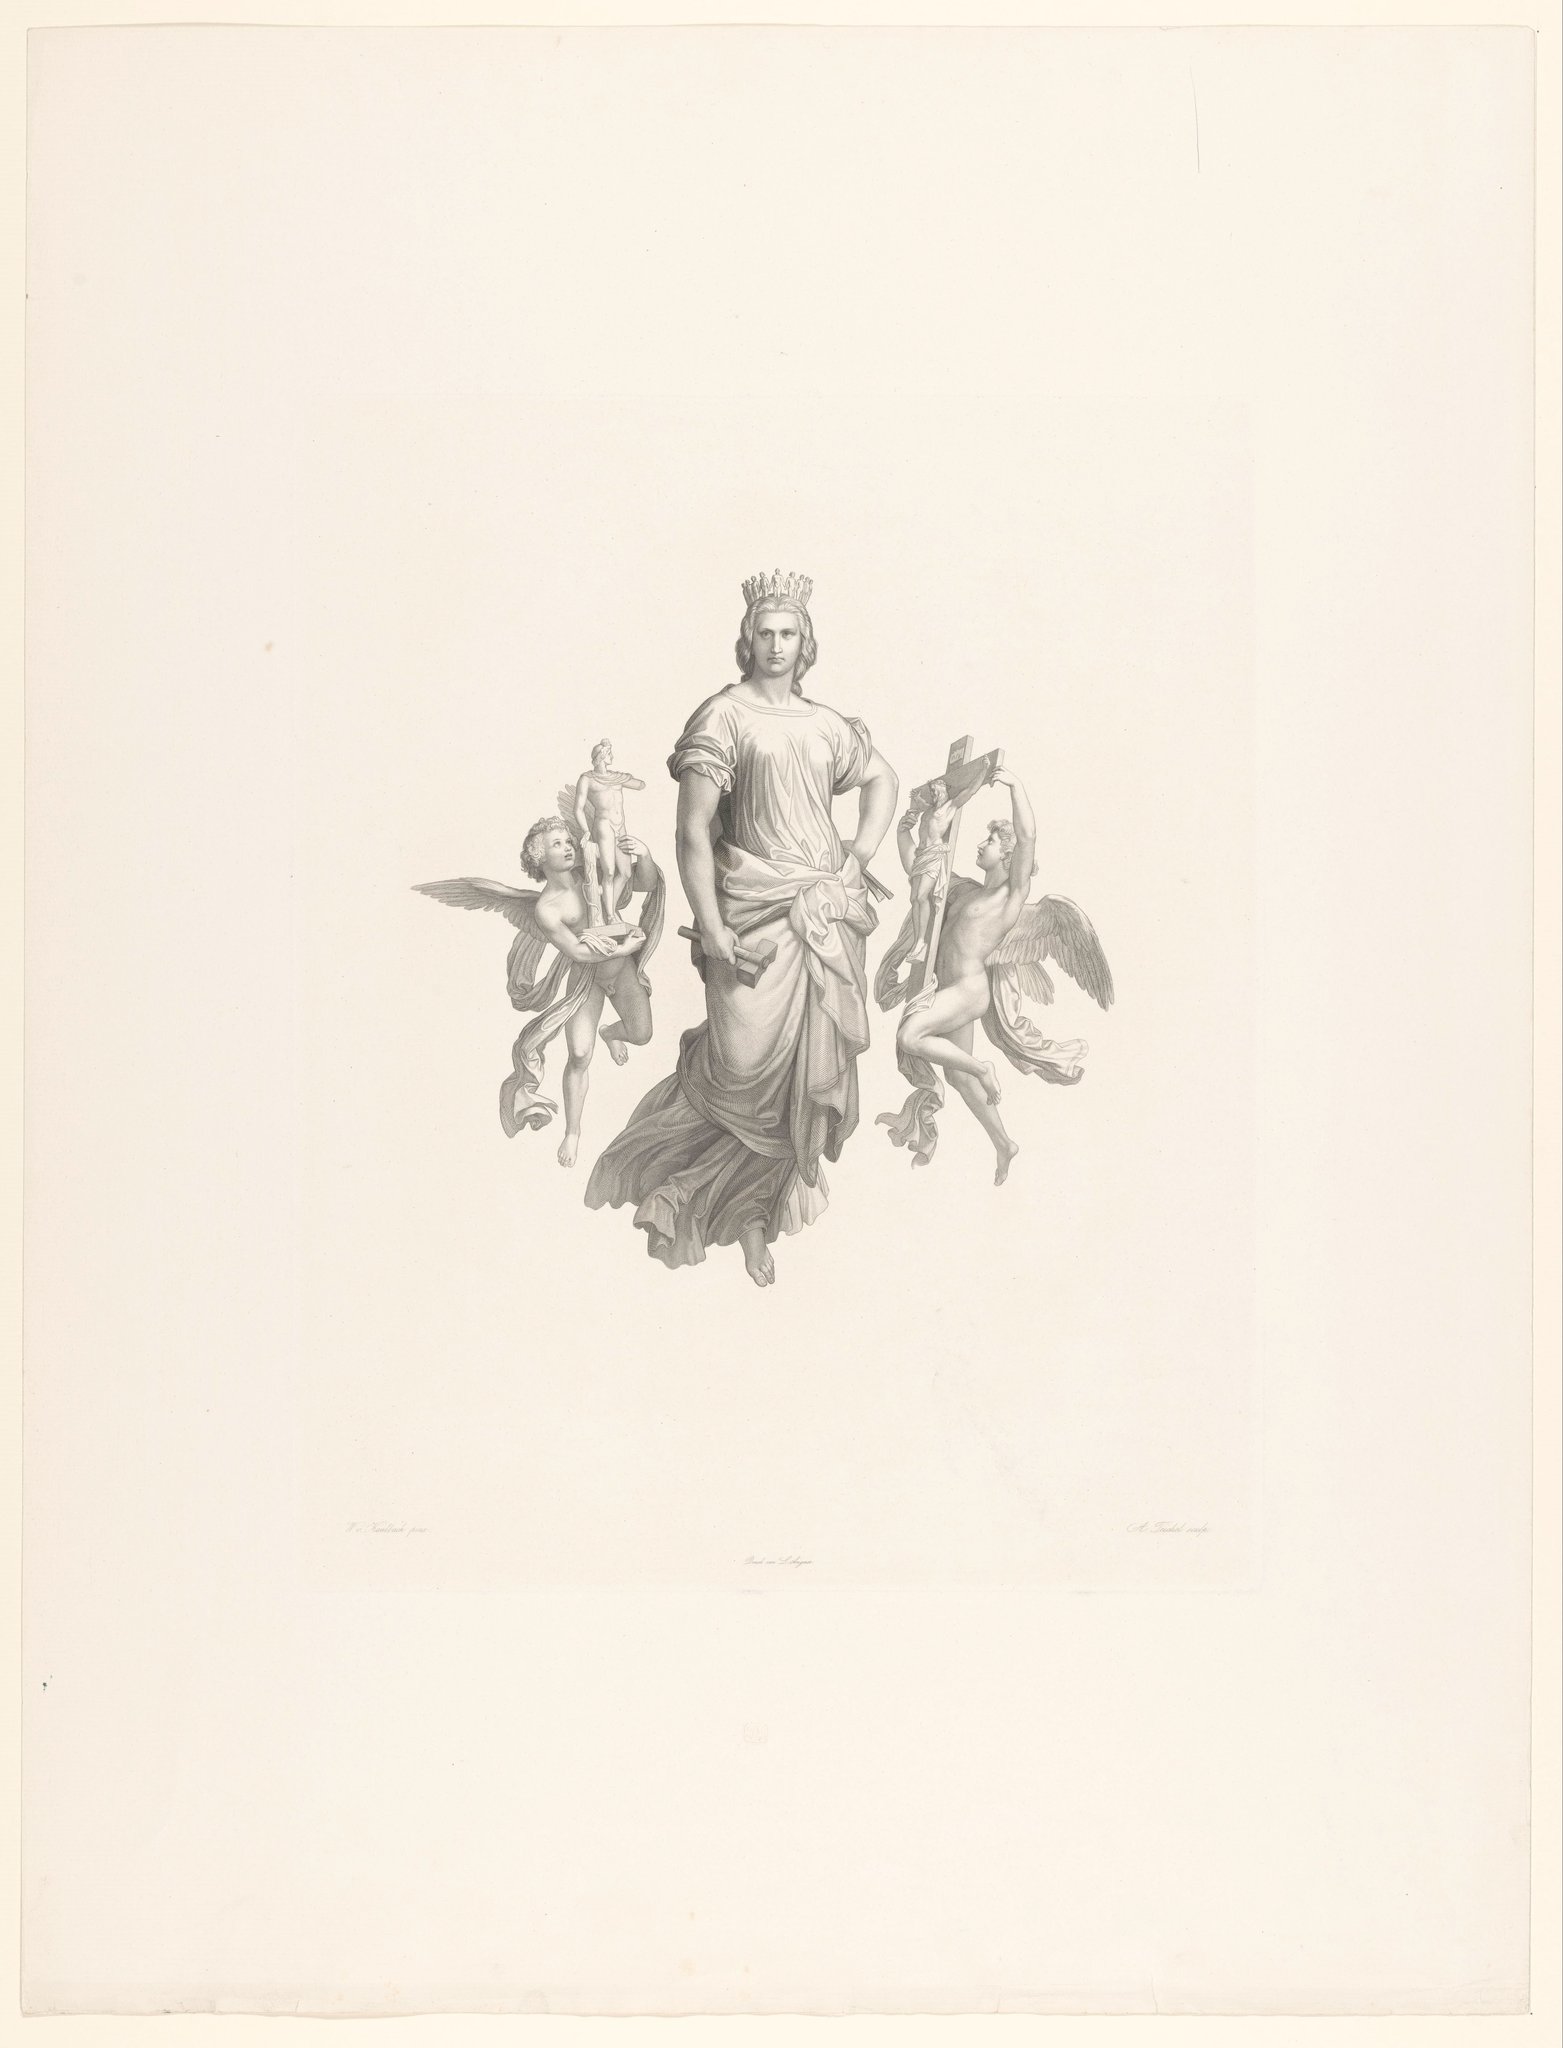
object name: print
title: Allegorie van de Beeldhouwkunst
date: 1832-1873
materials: paper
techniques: engraving, etching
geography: germany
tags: 'sculptura', symbolic representations, allegories and emblems ~ sculpture; 'scoltura' (ripa)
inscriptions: collector's mark: Lugt 2165